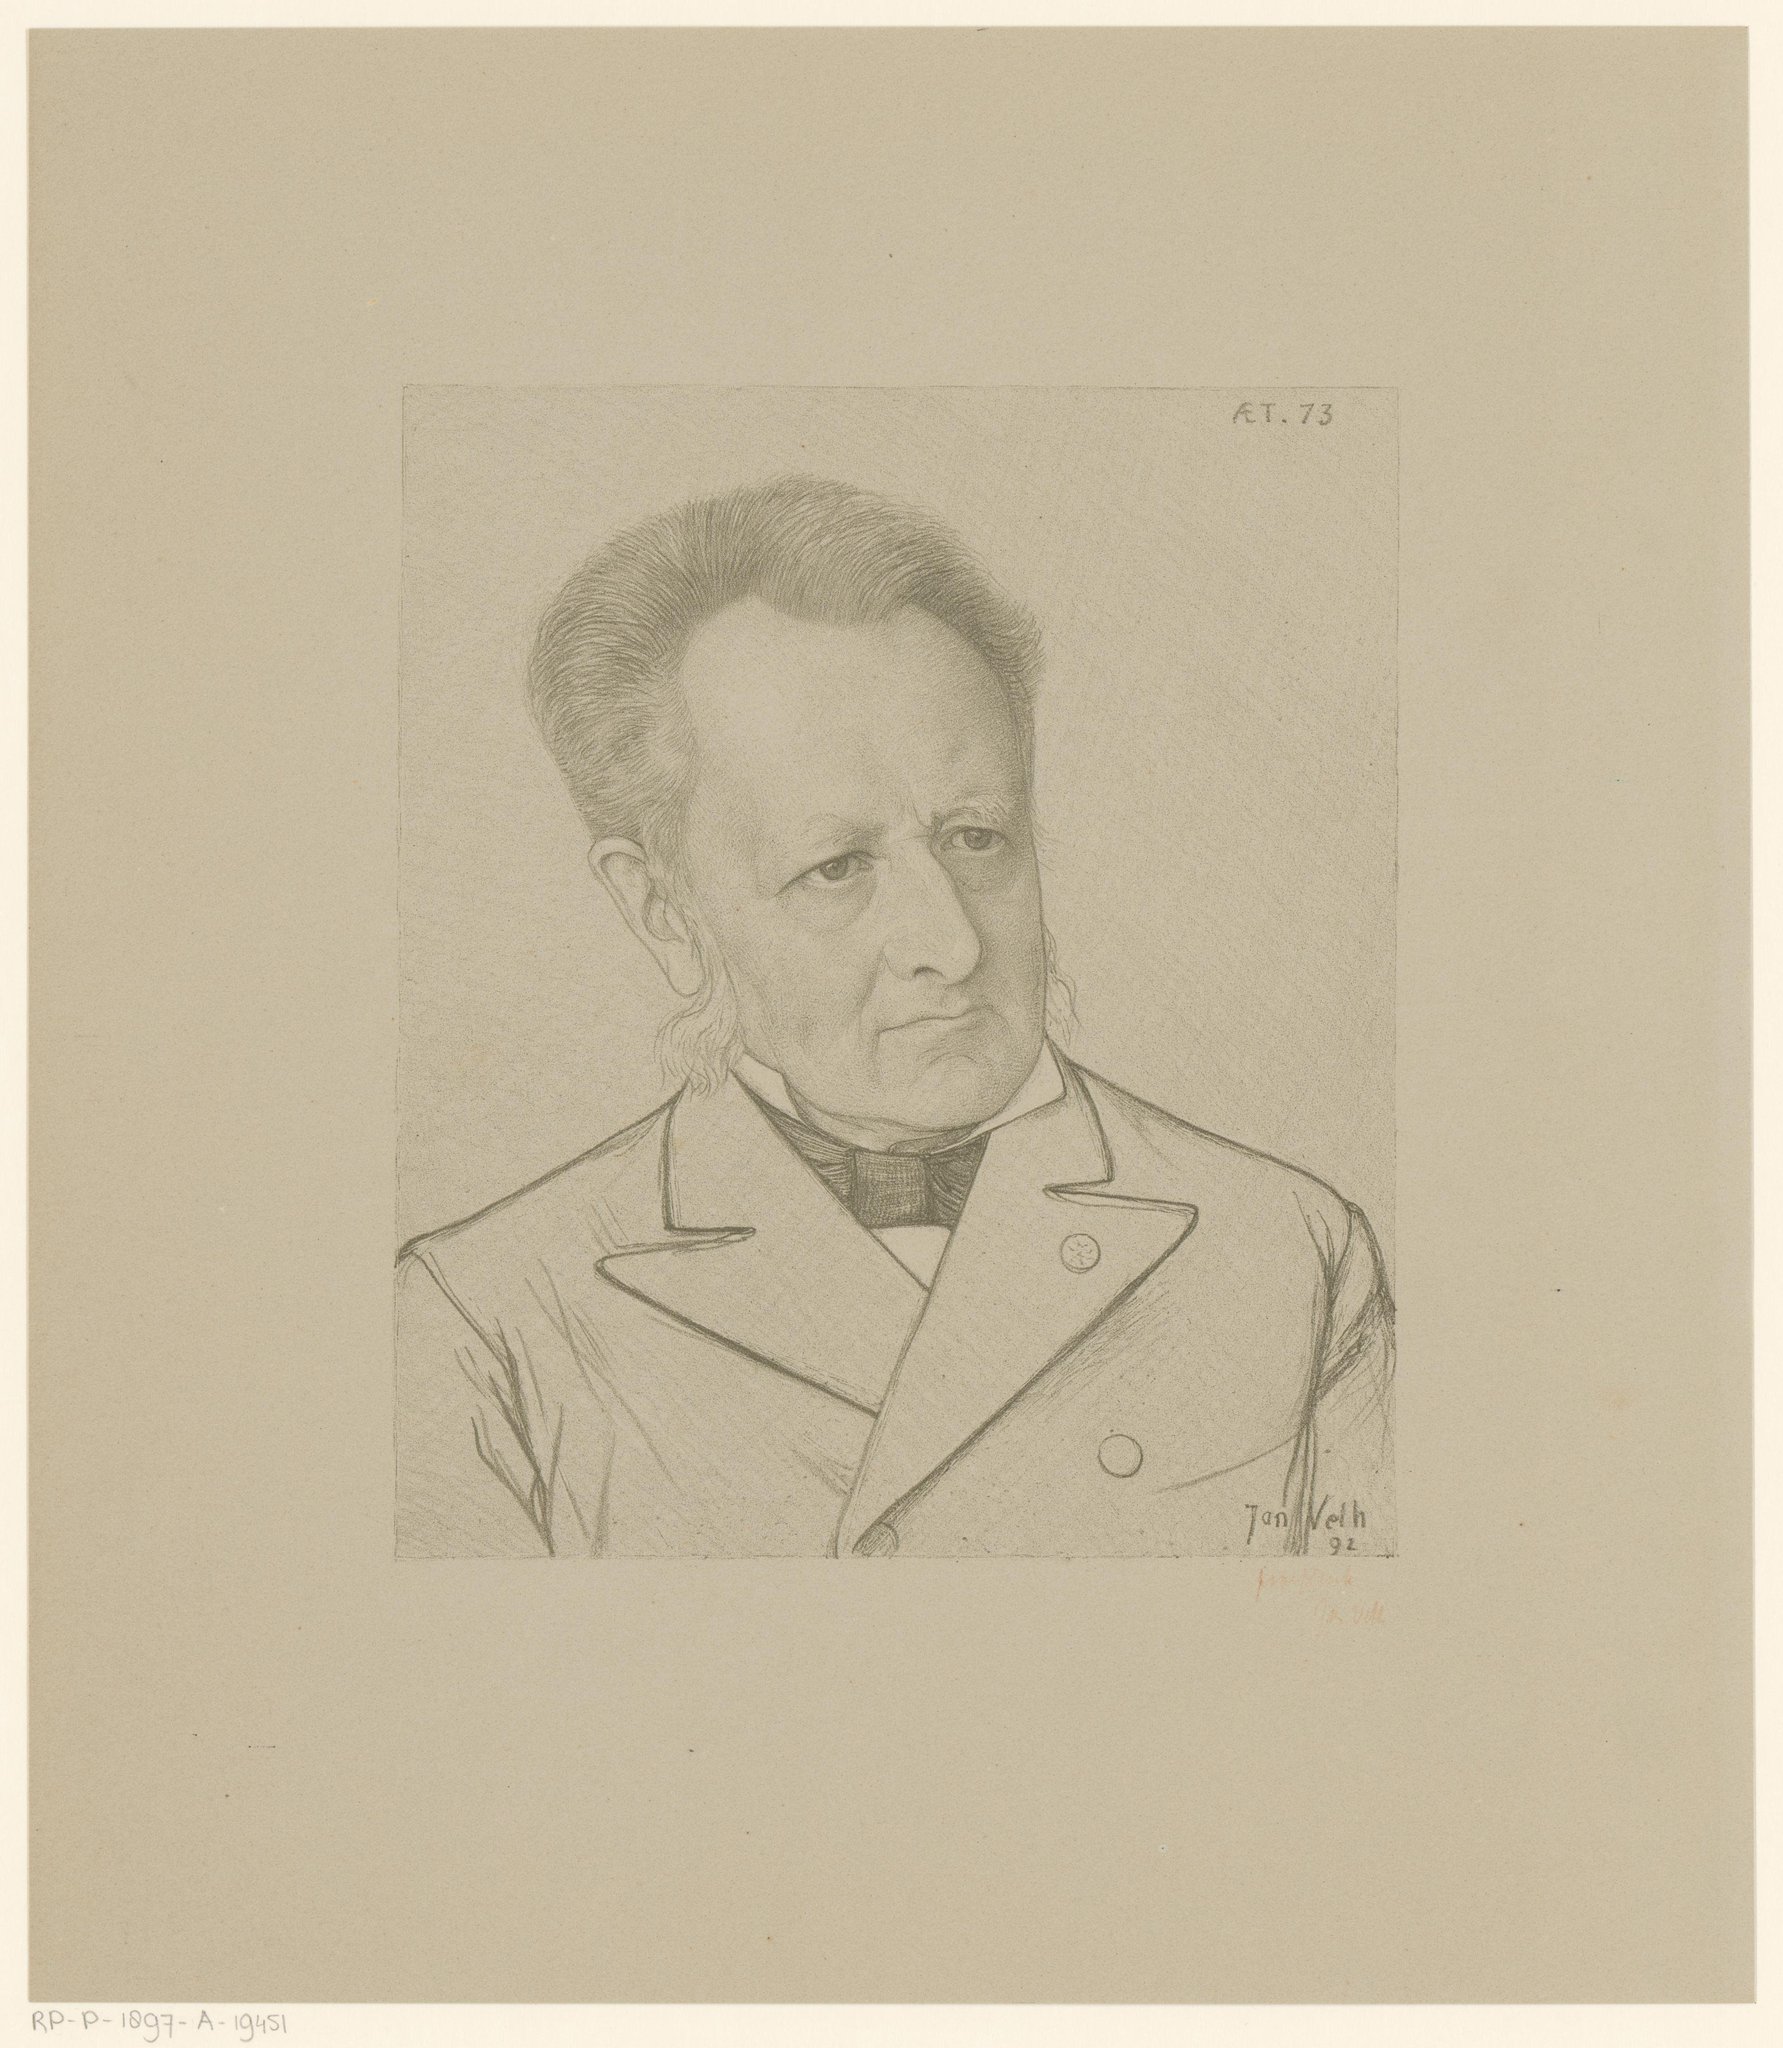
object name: print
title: Bekende tijdgenooten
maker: jan veth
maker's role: designer, draughtsman, painter, print maker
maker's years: 1864-1925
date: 1892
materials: paper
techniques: lithograph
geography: netherlands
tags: the hague, politician, historical persons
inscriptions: inscription: ‘proefdruk / Jan Veth’, collector's mark: Lugt 2228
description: Deze prent werd uitgegeven als bijvoegsel van De Amsterdammer op 26 juni 1892.